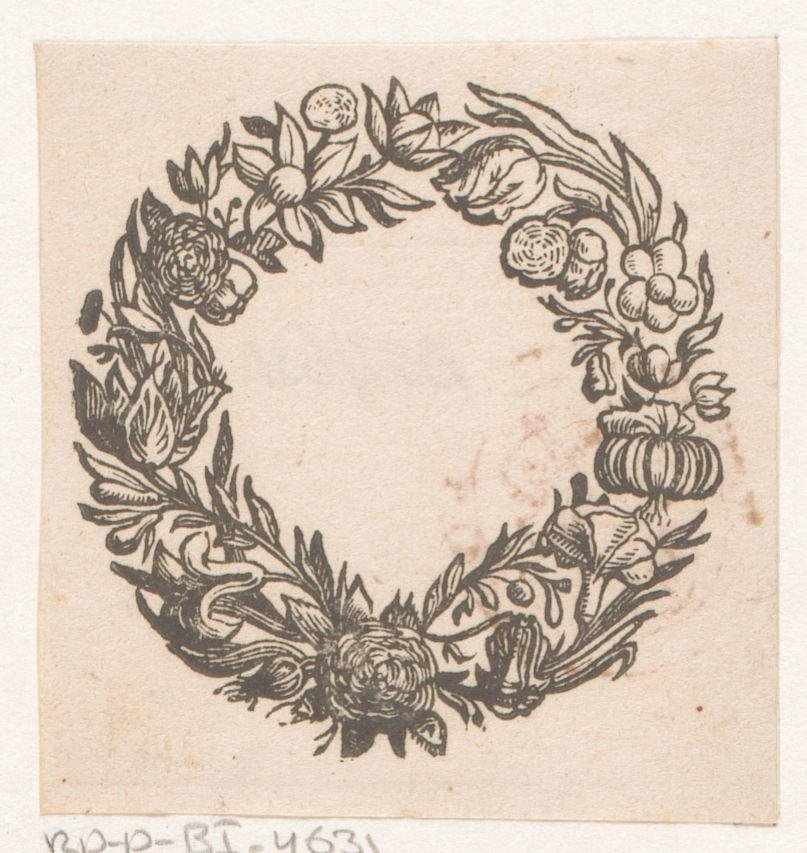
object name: print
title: Vignet met een ornament met bloemen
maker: Anonymous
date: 1600-1699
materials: paper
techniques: woodcut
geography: netherlands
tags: ornaments ~ art, vignette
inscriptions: collector's mark: Lugt 240